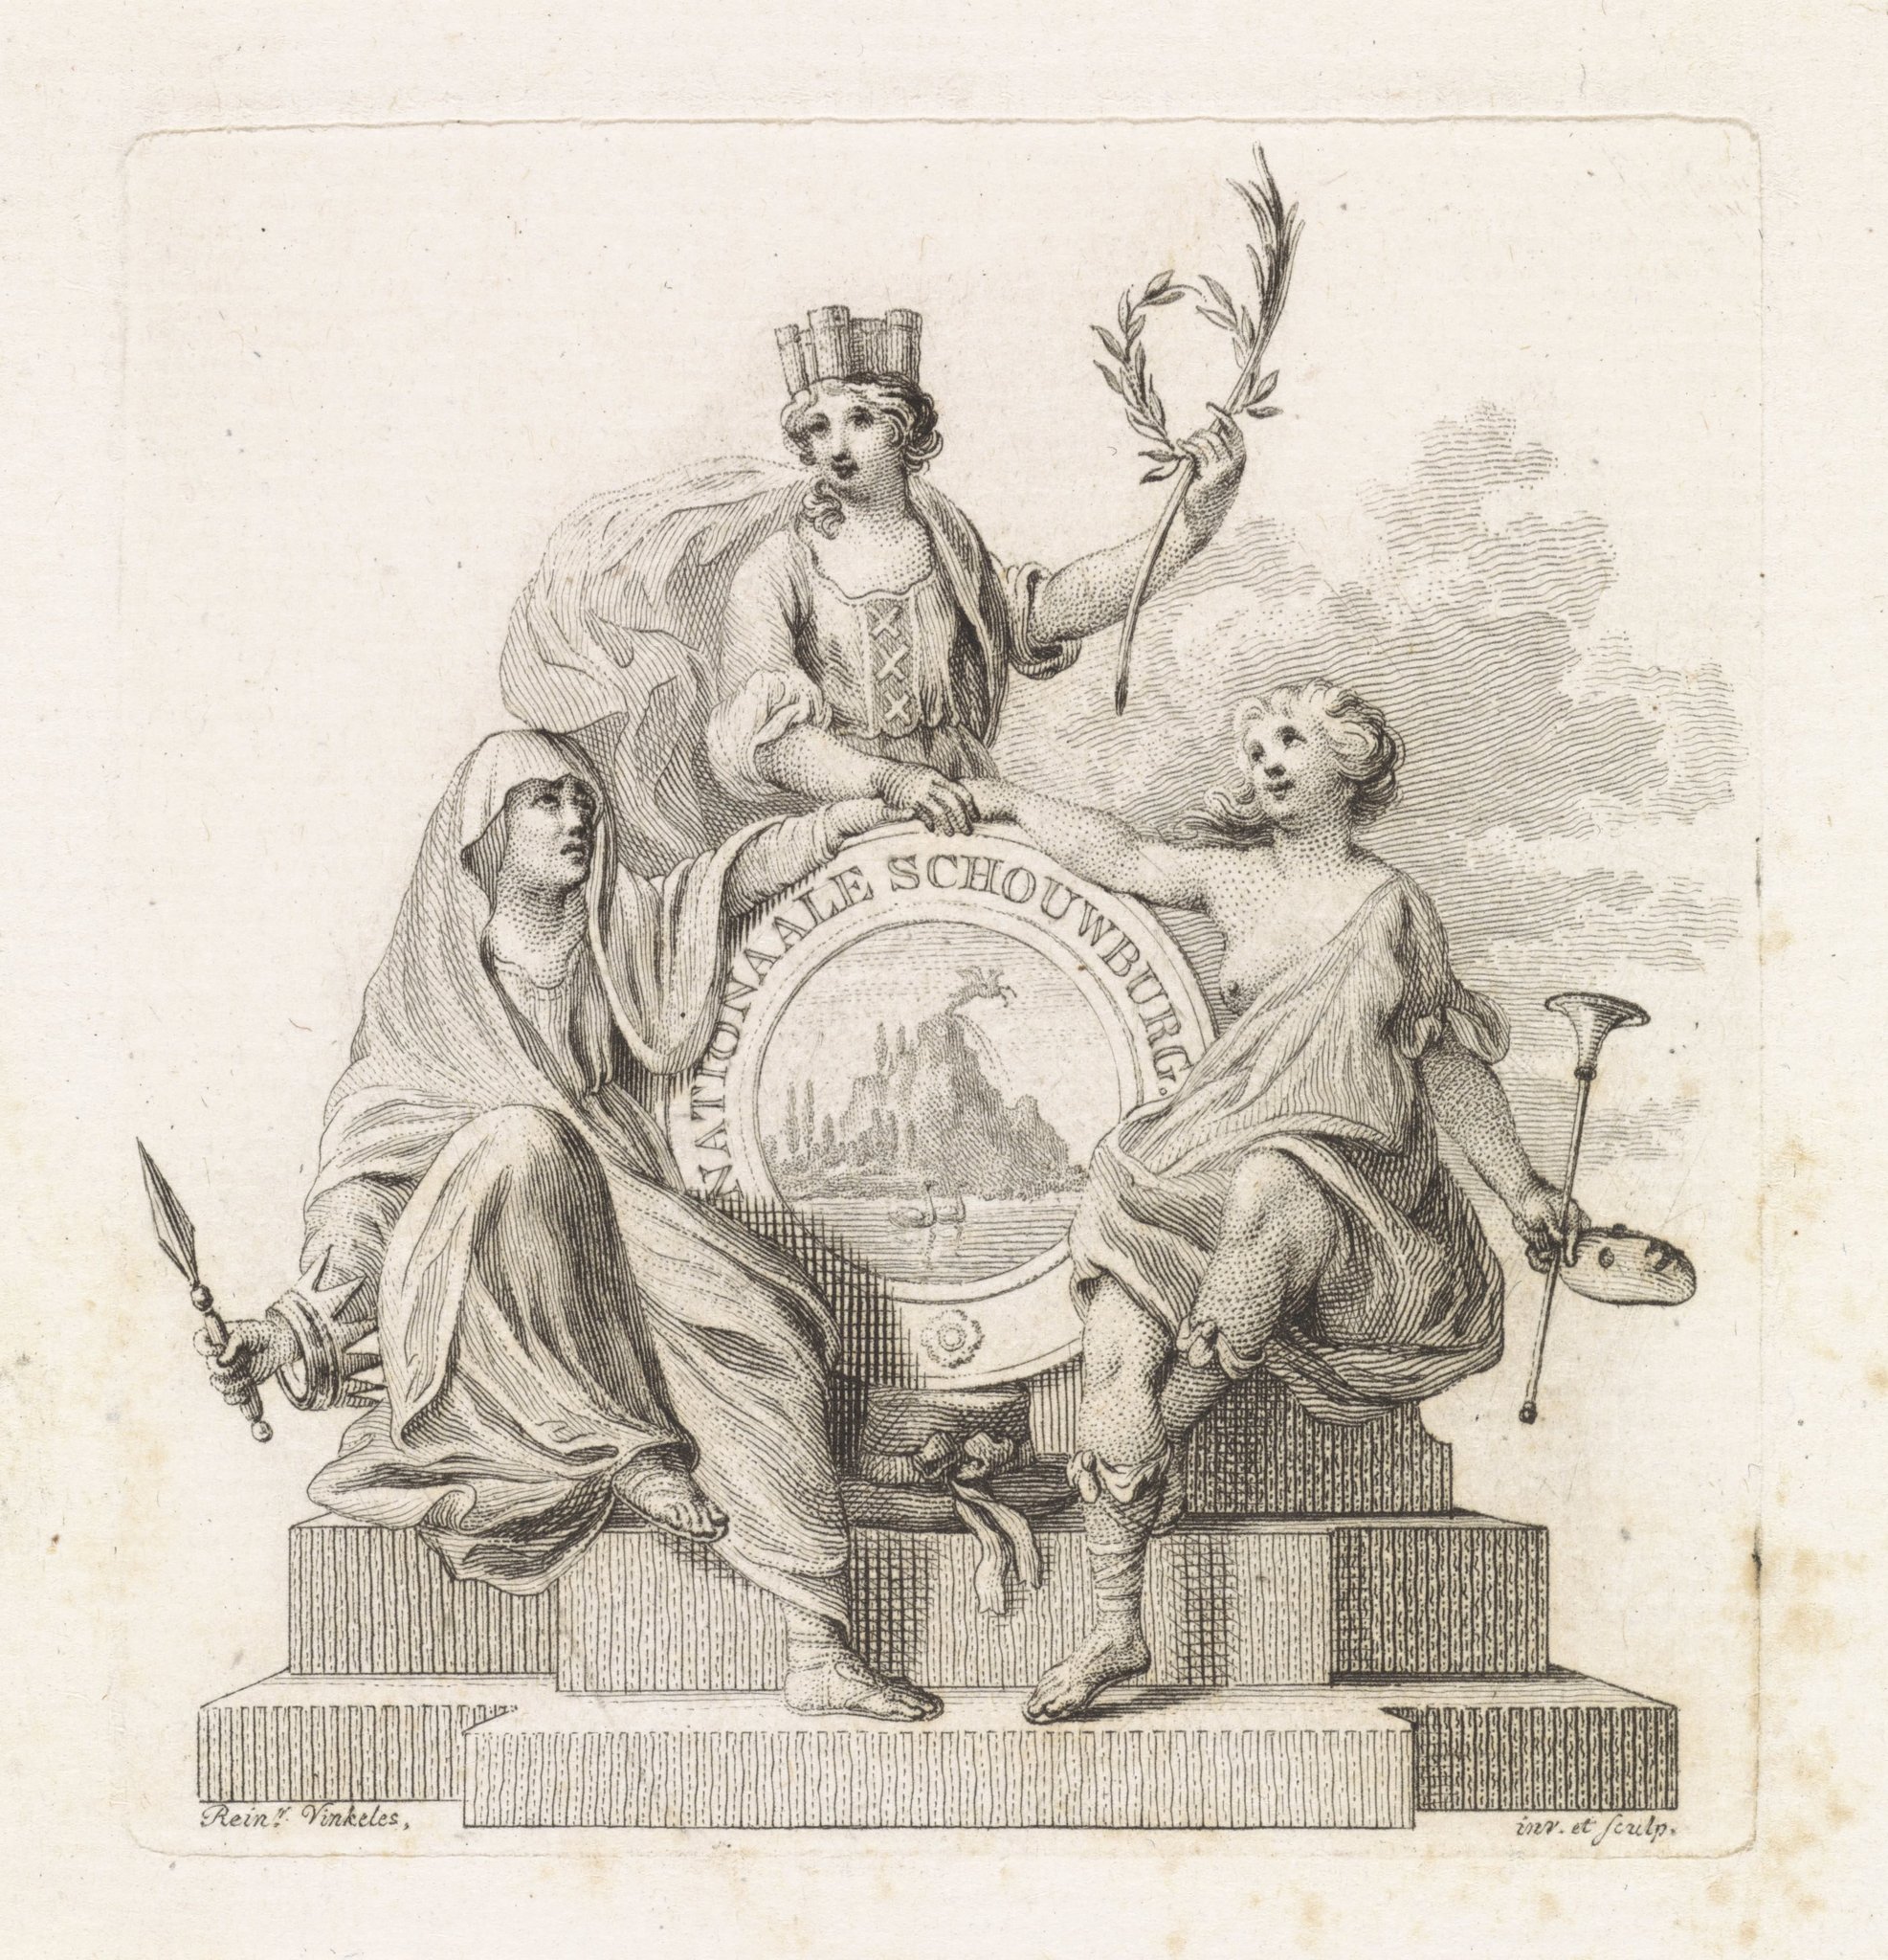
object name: print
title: Allegorische figuren bij een medaillon voor de nationale schouwburg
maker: reinier vinkeles (i)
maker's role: draughtsman, print maker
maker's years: 1741-1816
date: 1751-1816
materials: paper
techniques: engraving, etching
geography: amsterdam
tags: mask, crown (symbol of sovereignty), cities represented allegorically or symbolically, amsterdam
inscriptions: collector's mark: Lugt 2228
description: Op een trap zitten drie allegorische figuren bij een medaillon voor de nationale schouwburg. In het midden de stedenmaagd van Amsterdam en naast haar twee vrouwen met attributen zoals een kroon, een bazuin en een masker.